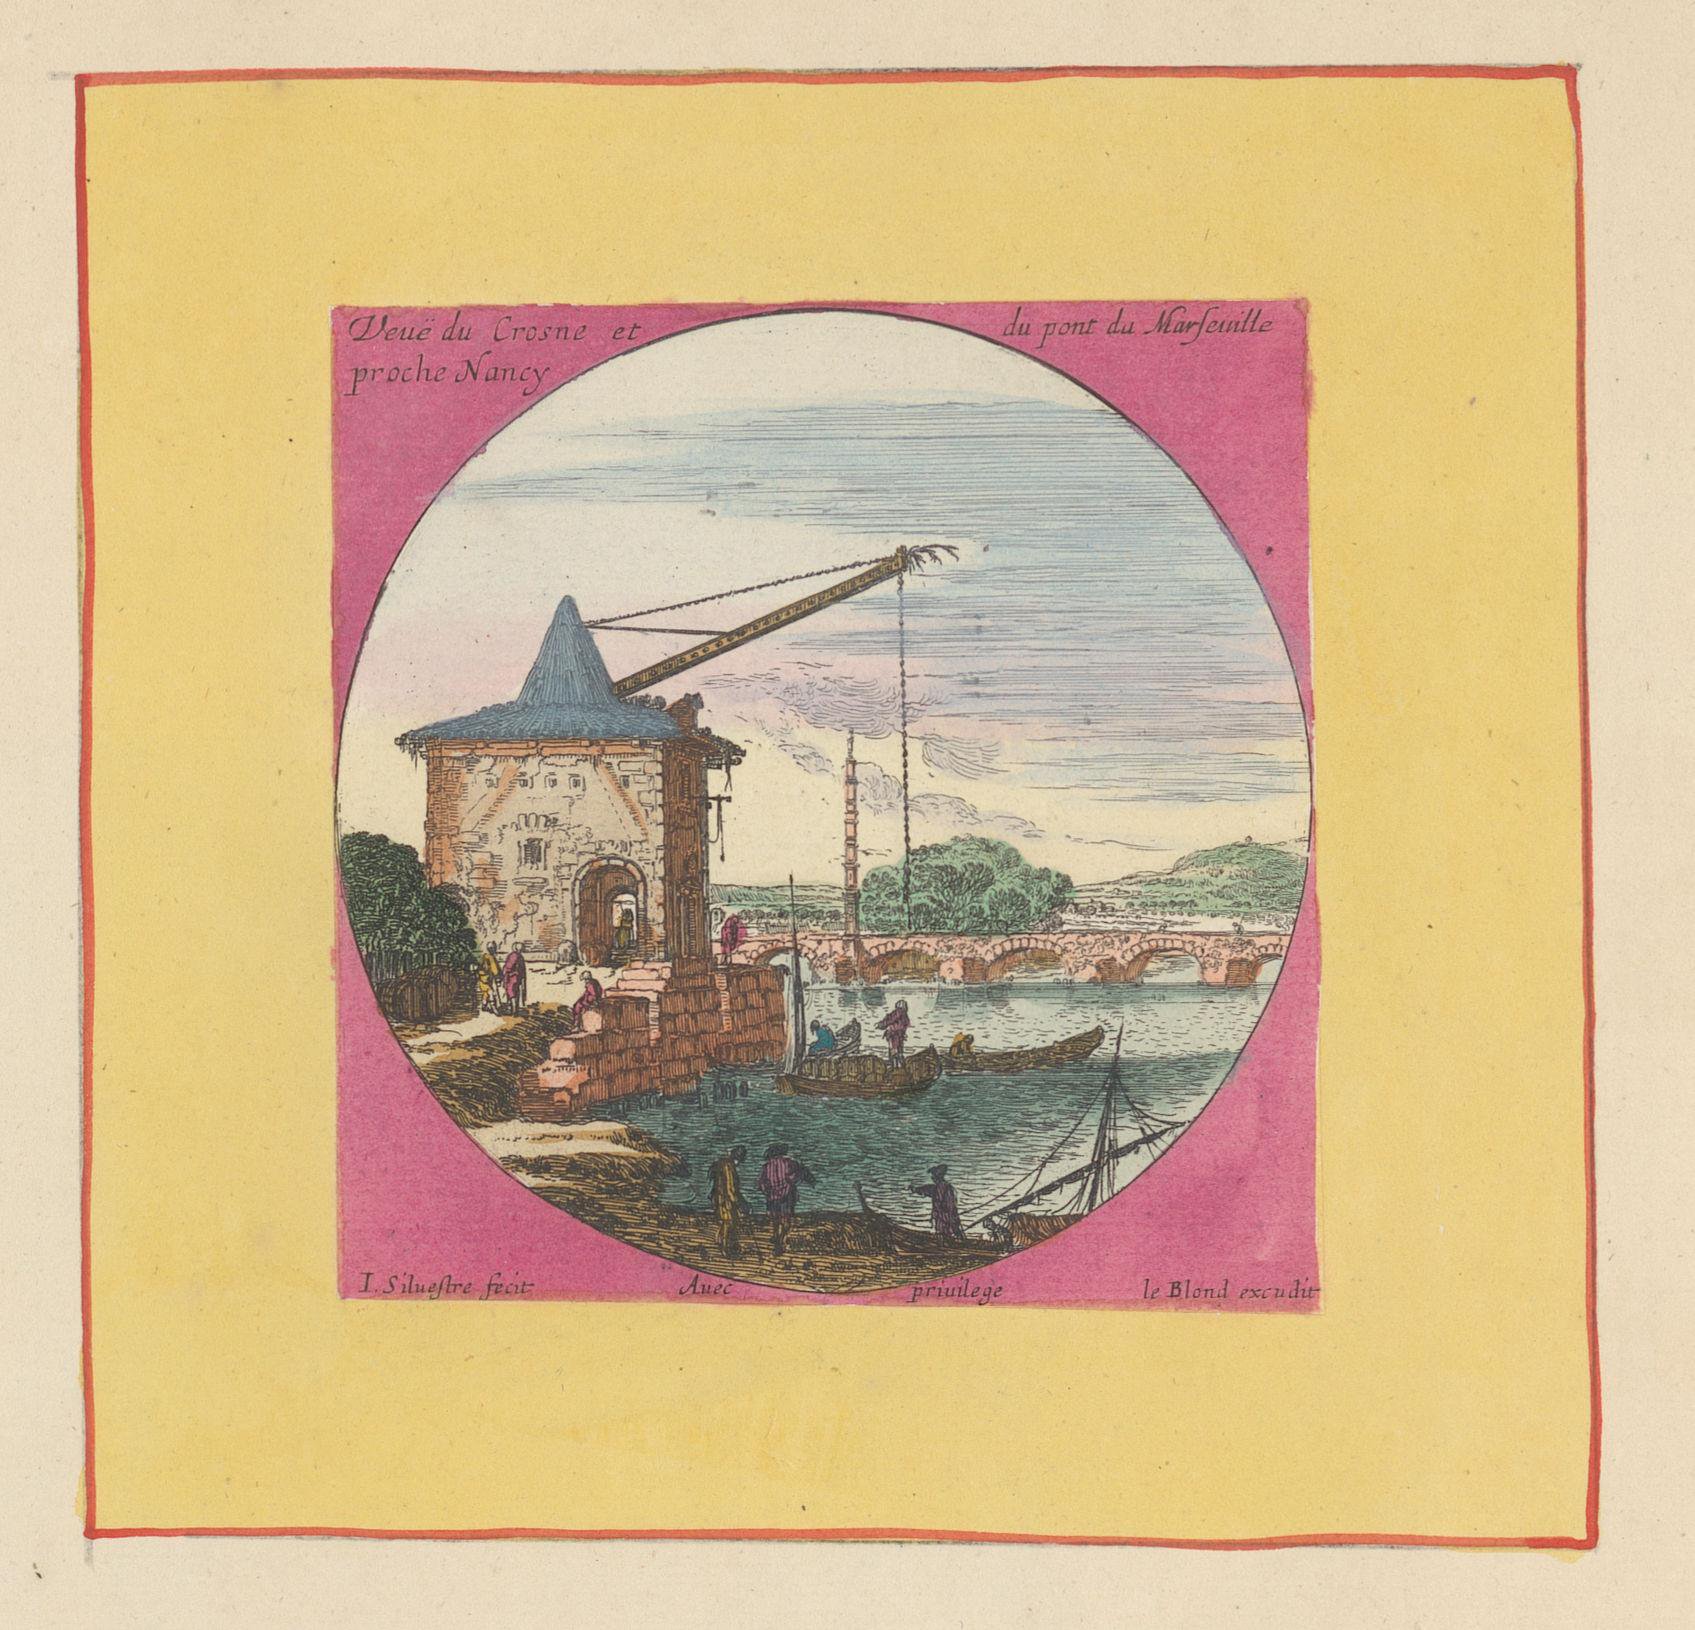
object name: print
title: Gezicht op een kraan en brug bij Nancy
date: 1635-1691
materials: paper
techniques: etching, hand coloring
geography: the hague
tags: landscape with bridge, viaduct or aqueduct, dock crane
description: Deze prent maakt deel uit van een album.